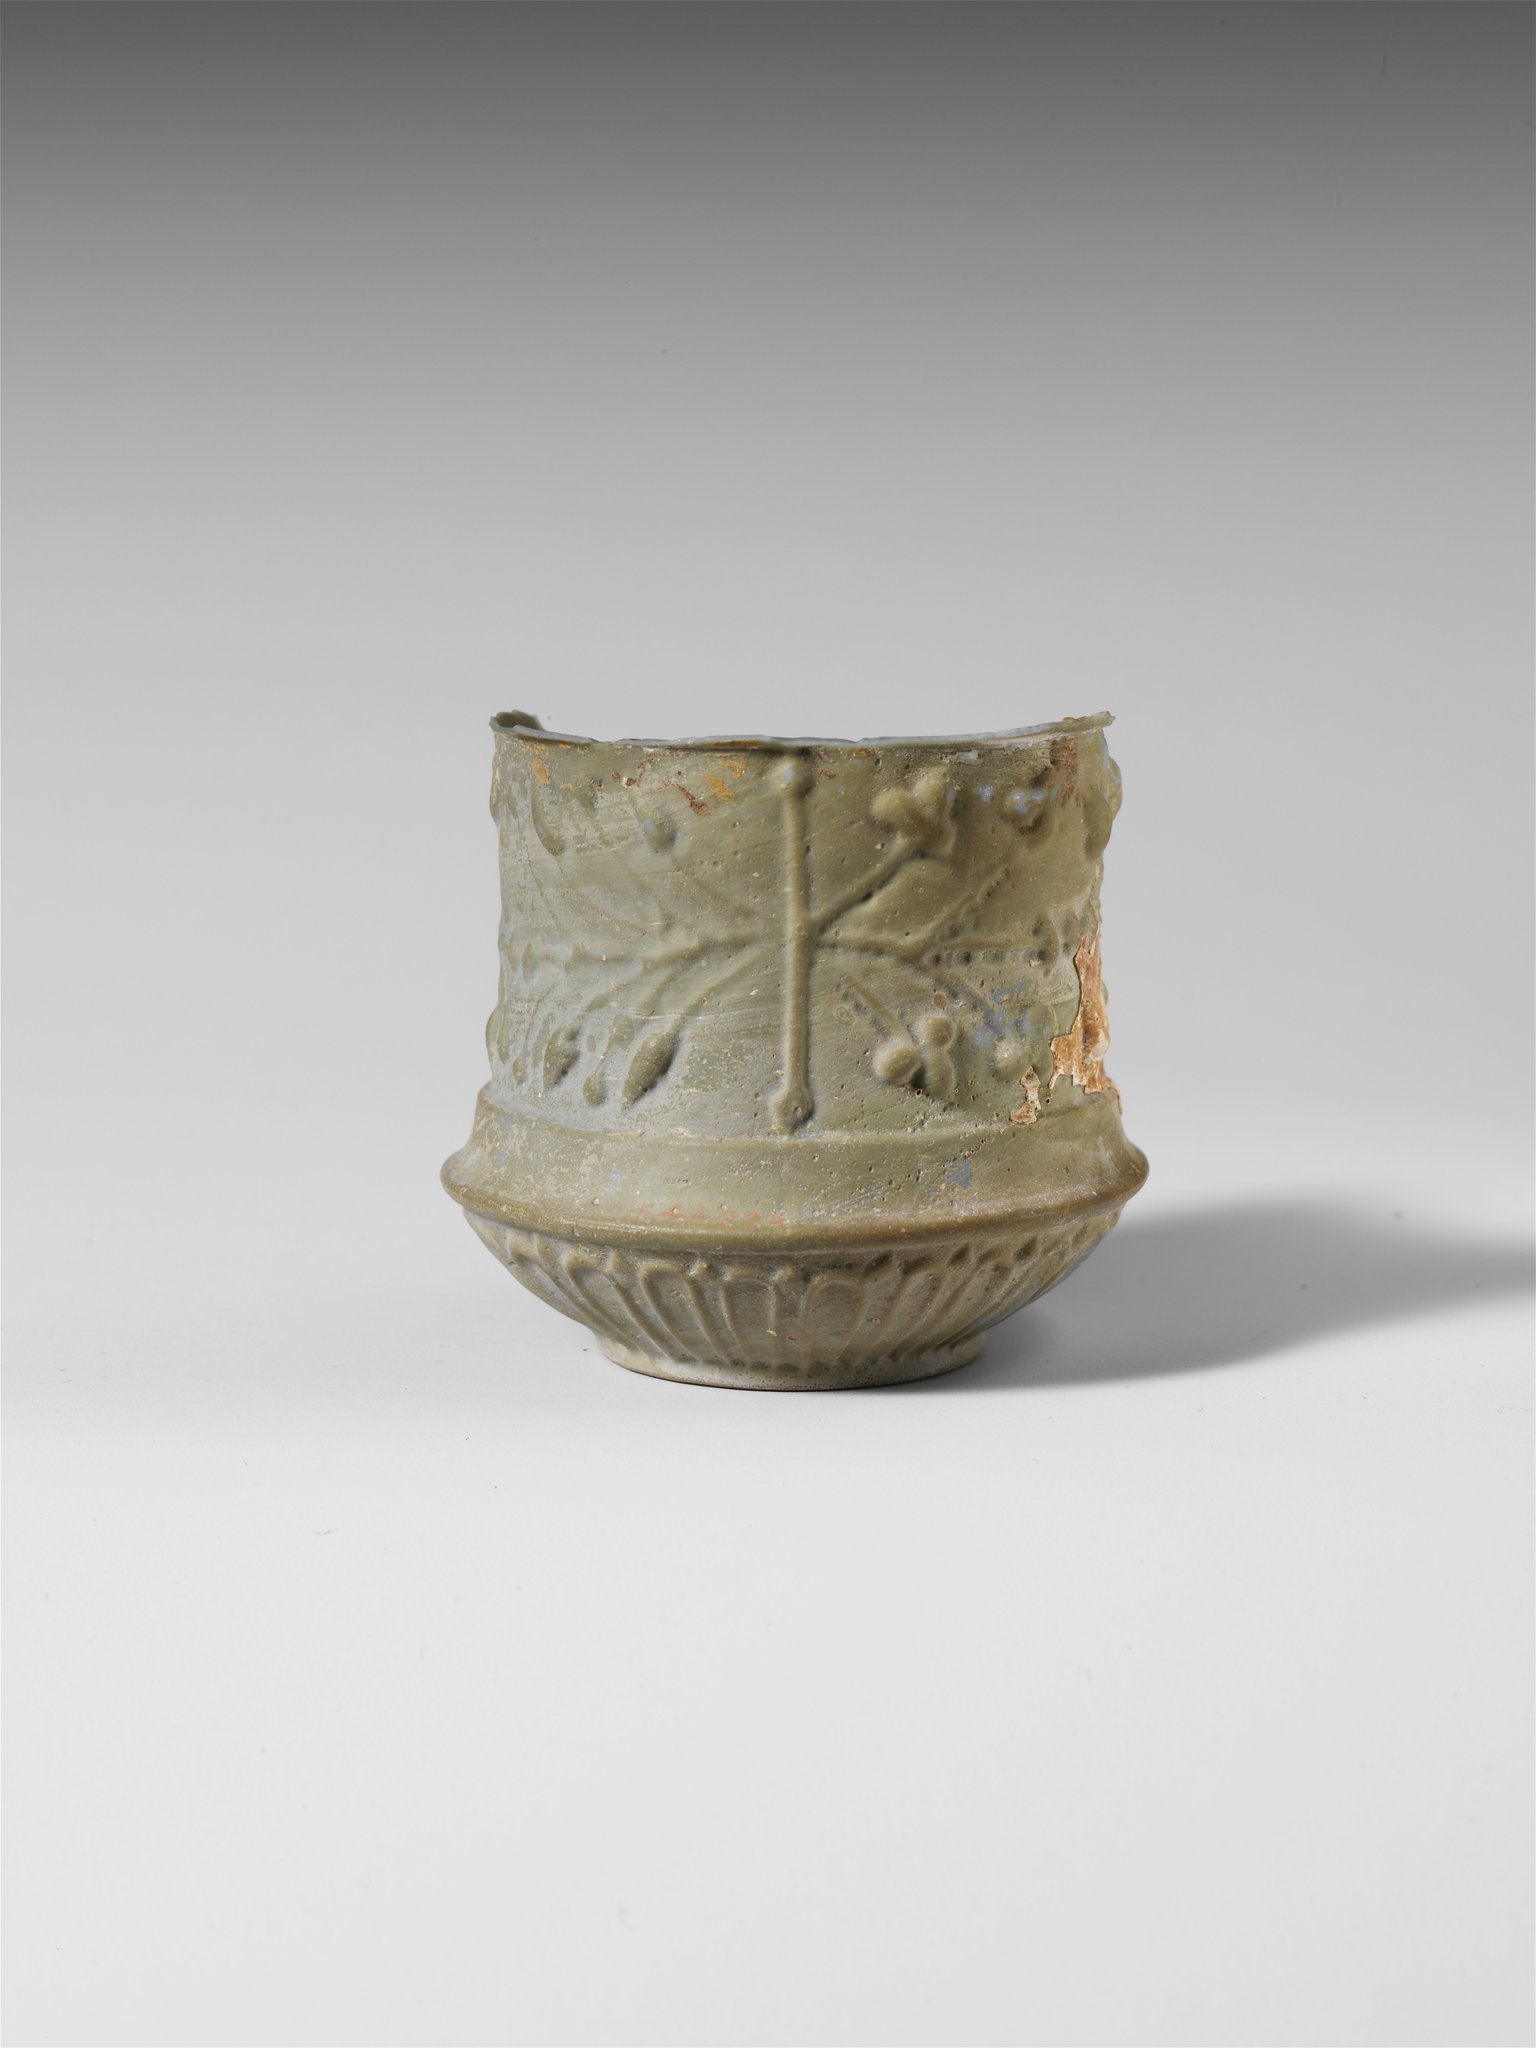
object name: fragmentary bottle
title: Glass fragmentary bottle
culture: roman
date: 1-50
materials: glass